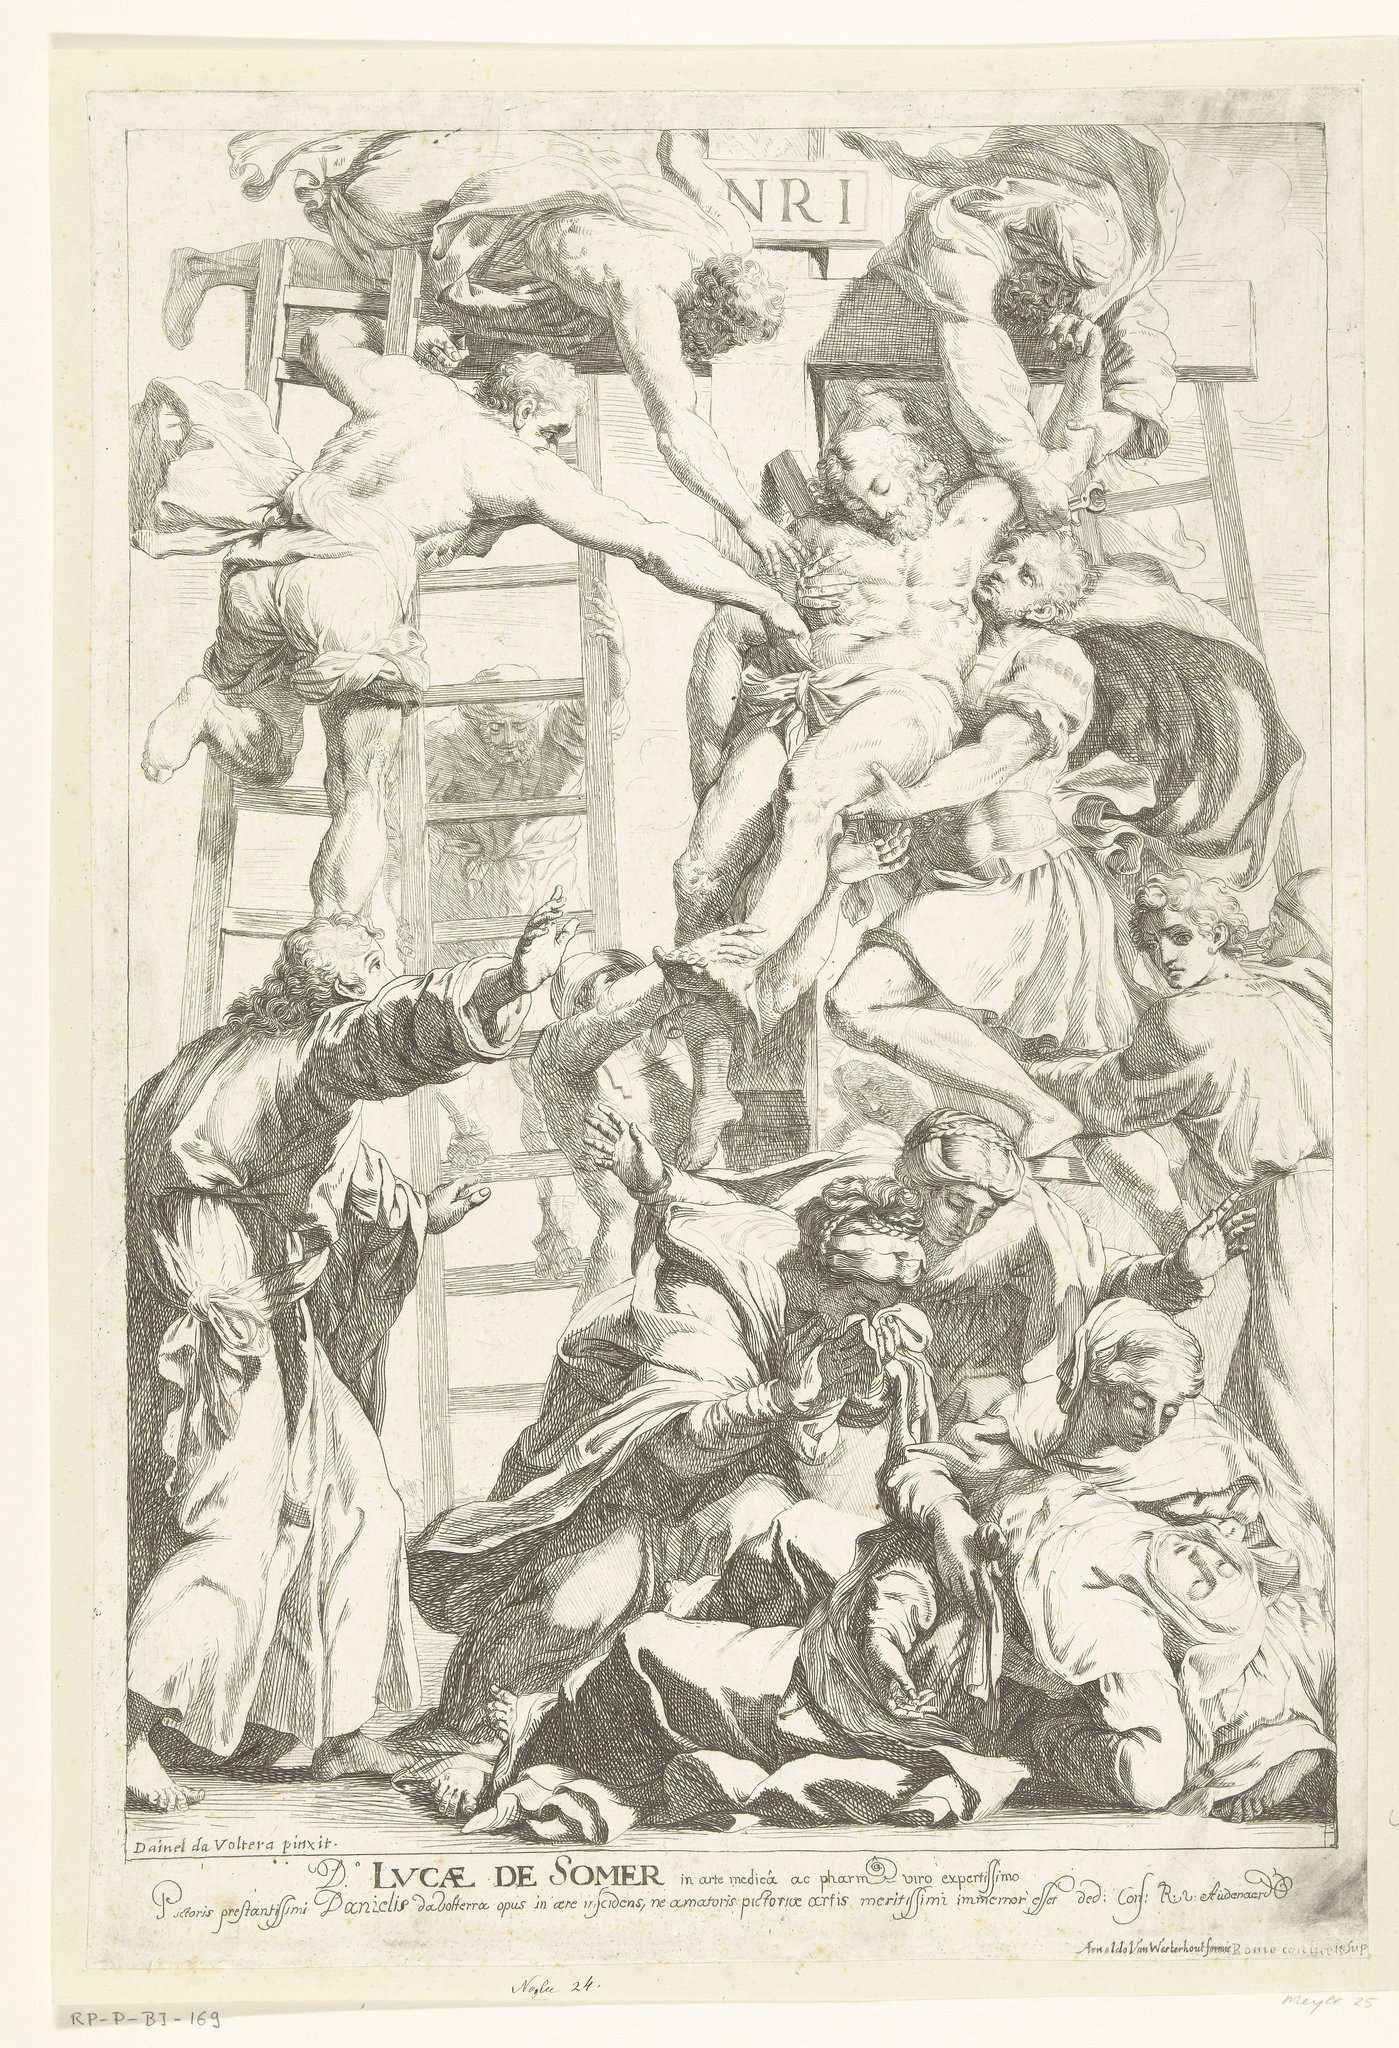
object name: print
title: De kruisafname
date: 1685-1700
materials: paper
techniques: etching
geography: rome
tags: descent from the cross: christ is taken down from the cross, usually by nicodemus and joseph of arimathaea who are standing on the ladders (both arms of christ detached)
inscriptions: collector's mark: Lugt 2228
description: Een aantal mannen halen het lichaam van Christus van het kruis. Links op de voorgrond staat Johannes de Evangelist die helpt bij het opvangen van het lichaam. Maria is flauw gevallen en een aantal vrouwen ontfermen zich over haar.